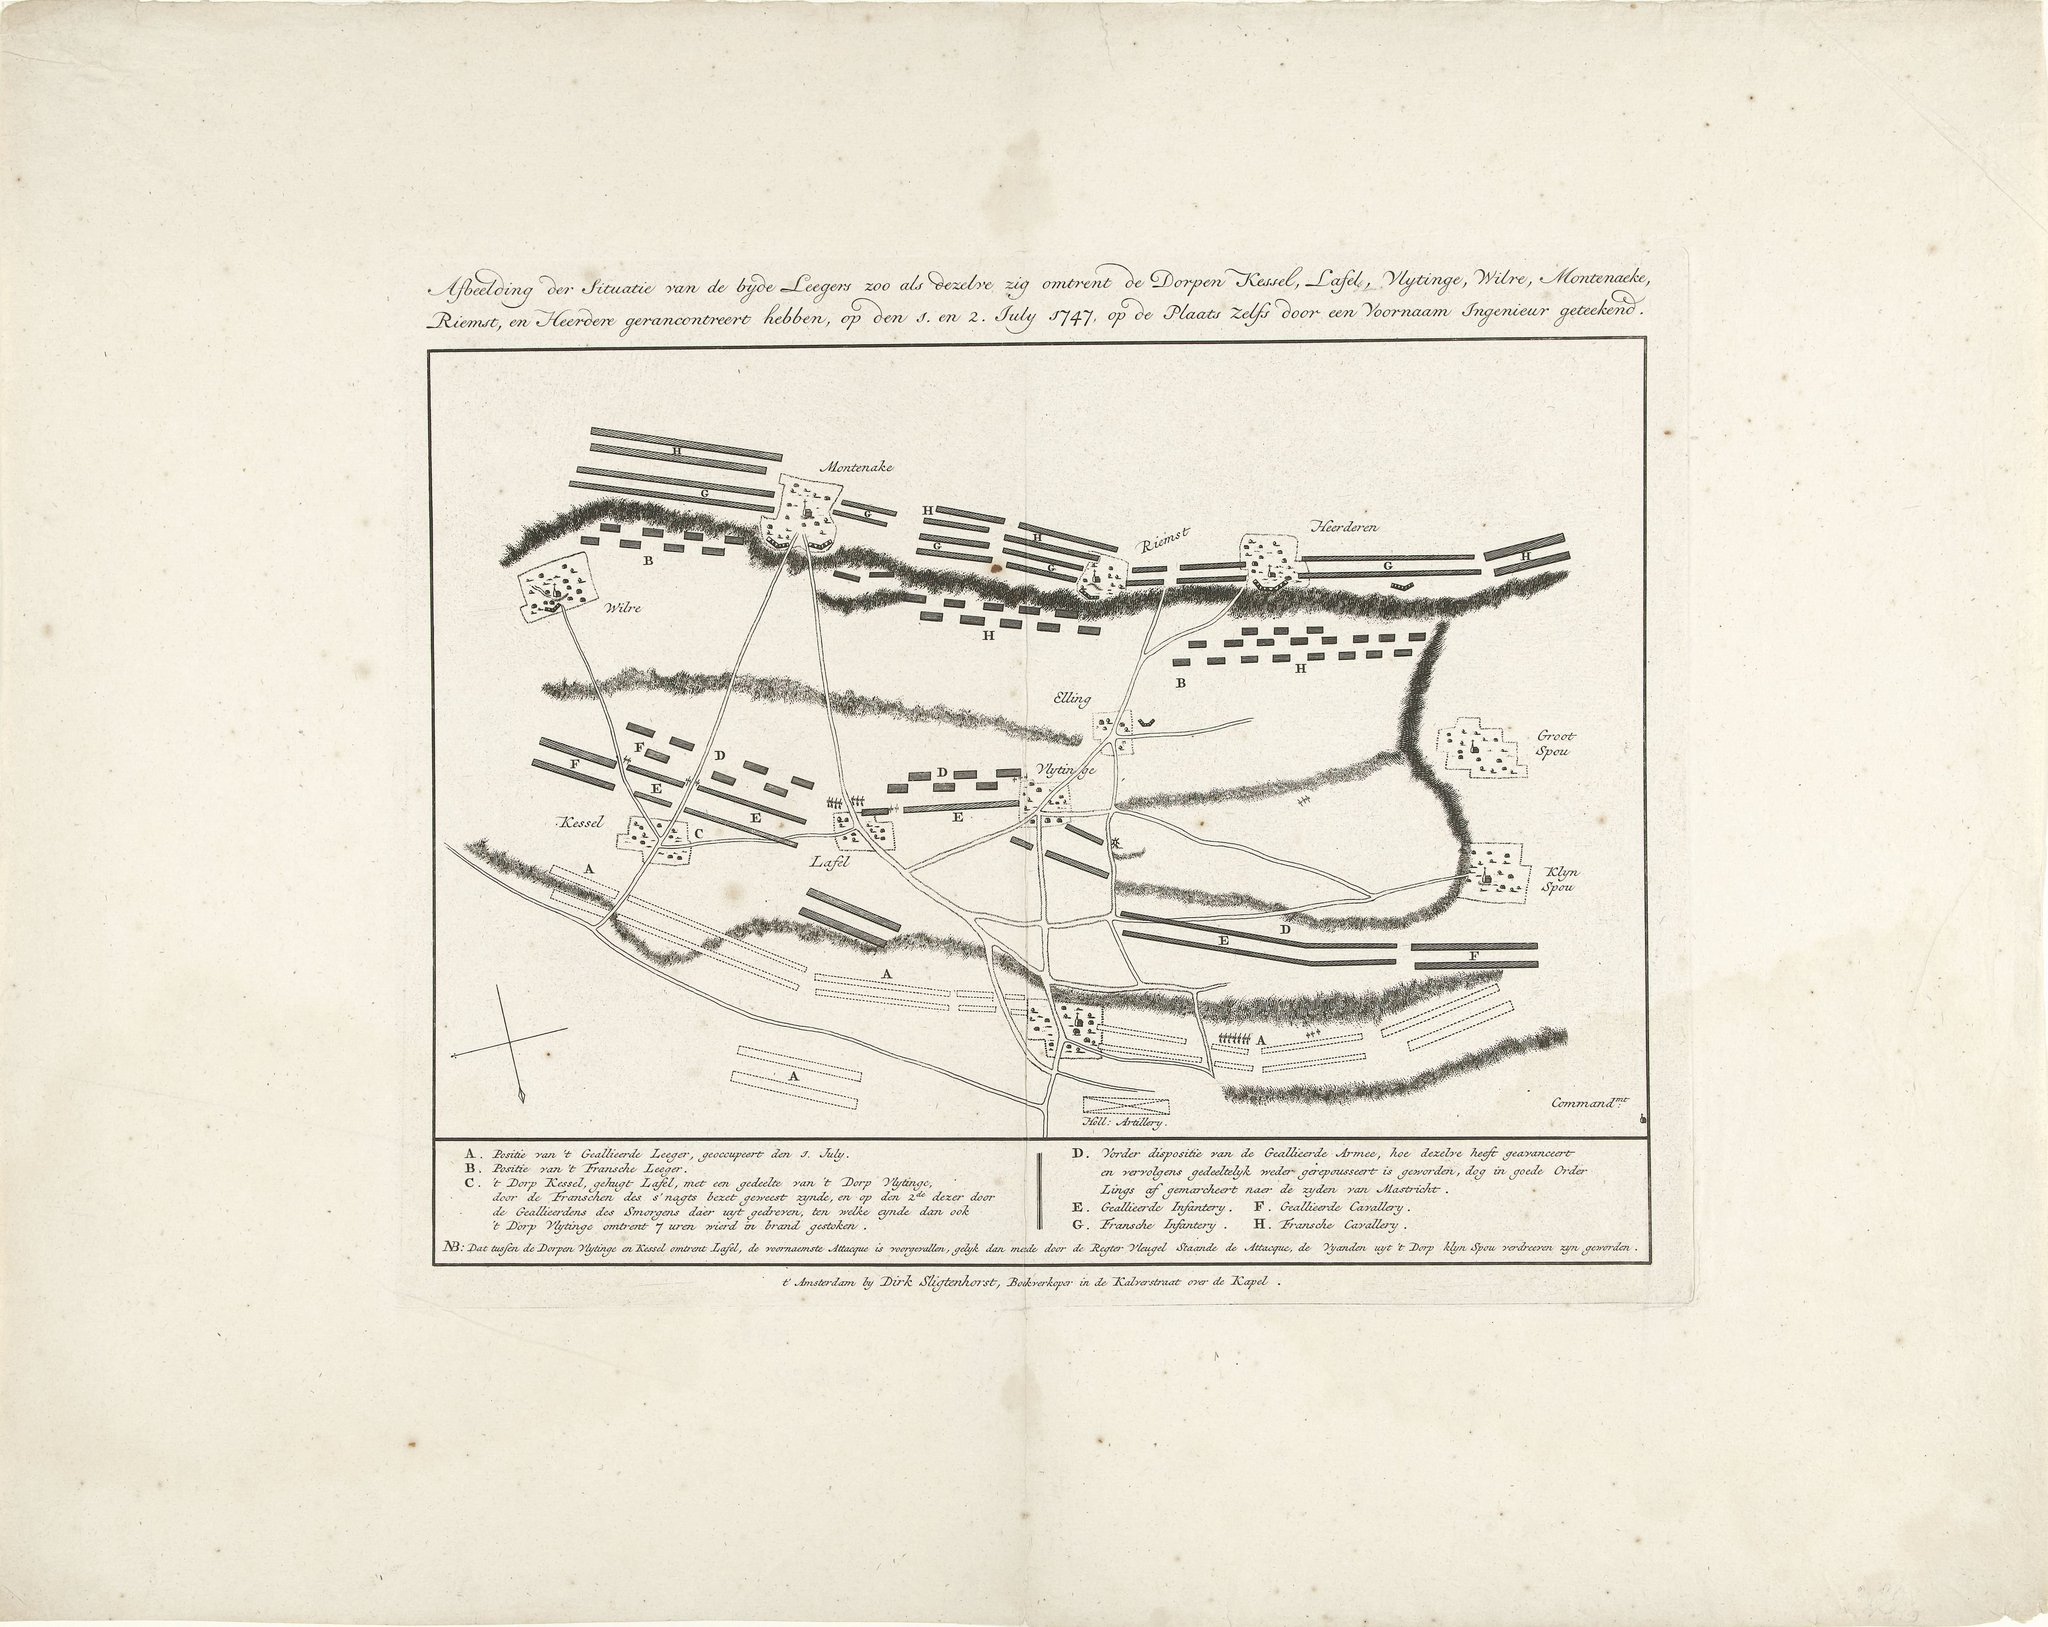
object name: print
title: Afbeelding der Situatie van de byde Leegers zoo als dezelve zig omtrent de Dorpen Kessel, Lafel, Vlytinge, Wilre, Montenaeke, Riemst, en Heerdere gerancontreert hebben, op den 1. en 2. July 1747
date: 1747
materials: paper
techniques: etching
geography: northern netherlands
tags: battle (+ naval force), battle arrays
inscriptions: collector's mark: Lugt 2228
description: Plattegrond met de slagordes bij de slag bij Lafelt waarbij de Fransen een overwinning behaalden op de Geallieerden, 2 juli 1747. In het onderschrift de legenda A-H in het Nederlands.